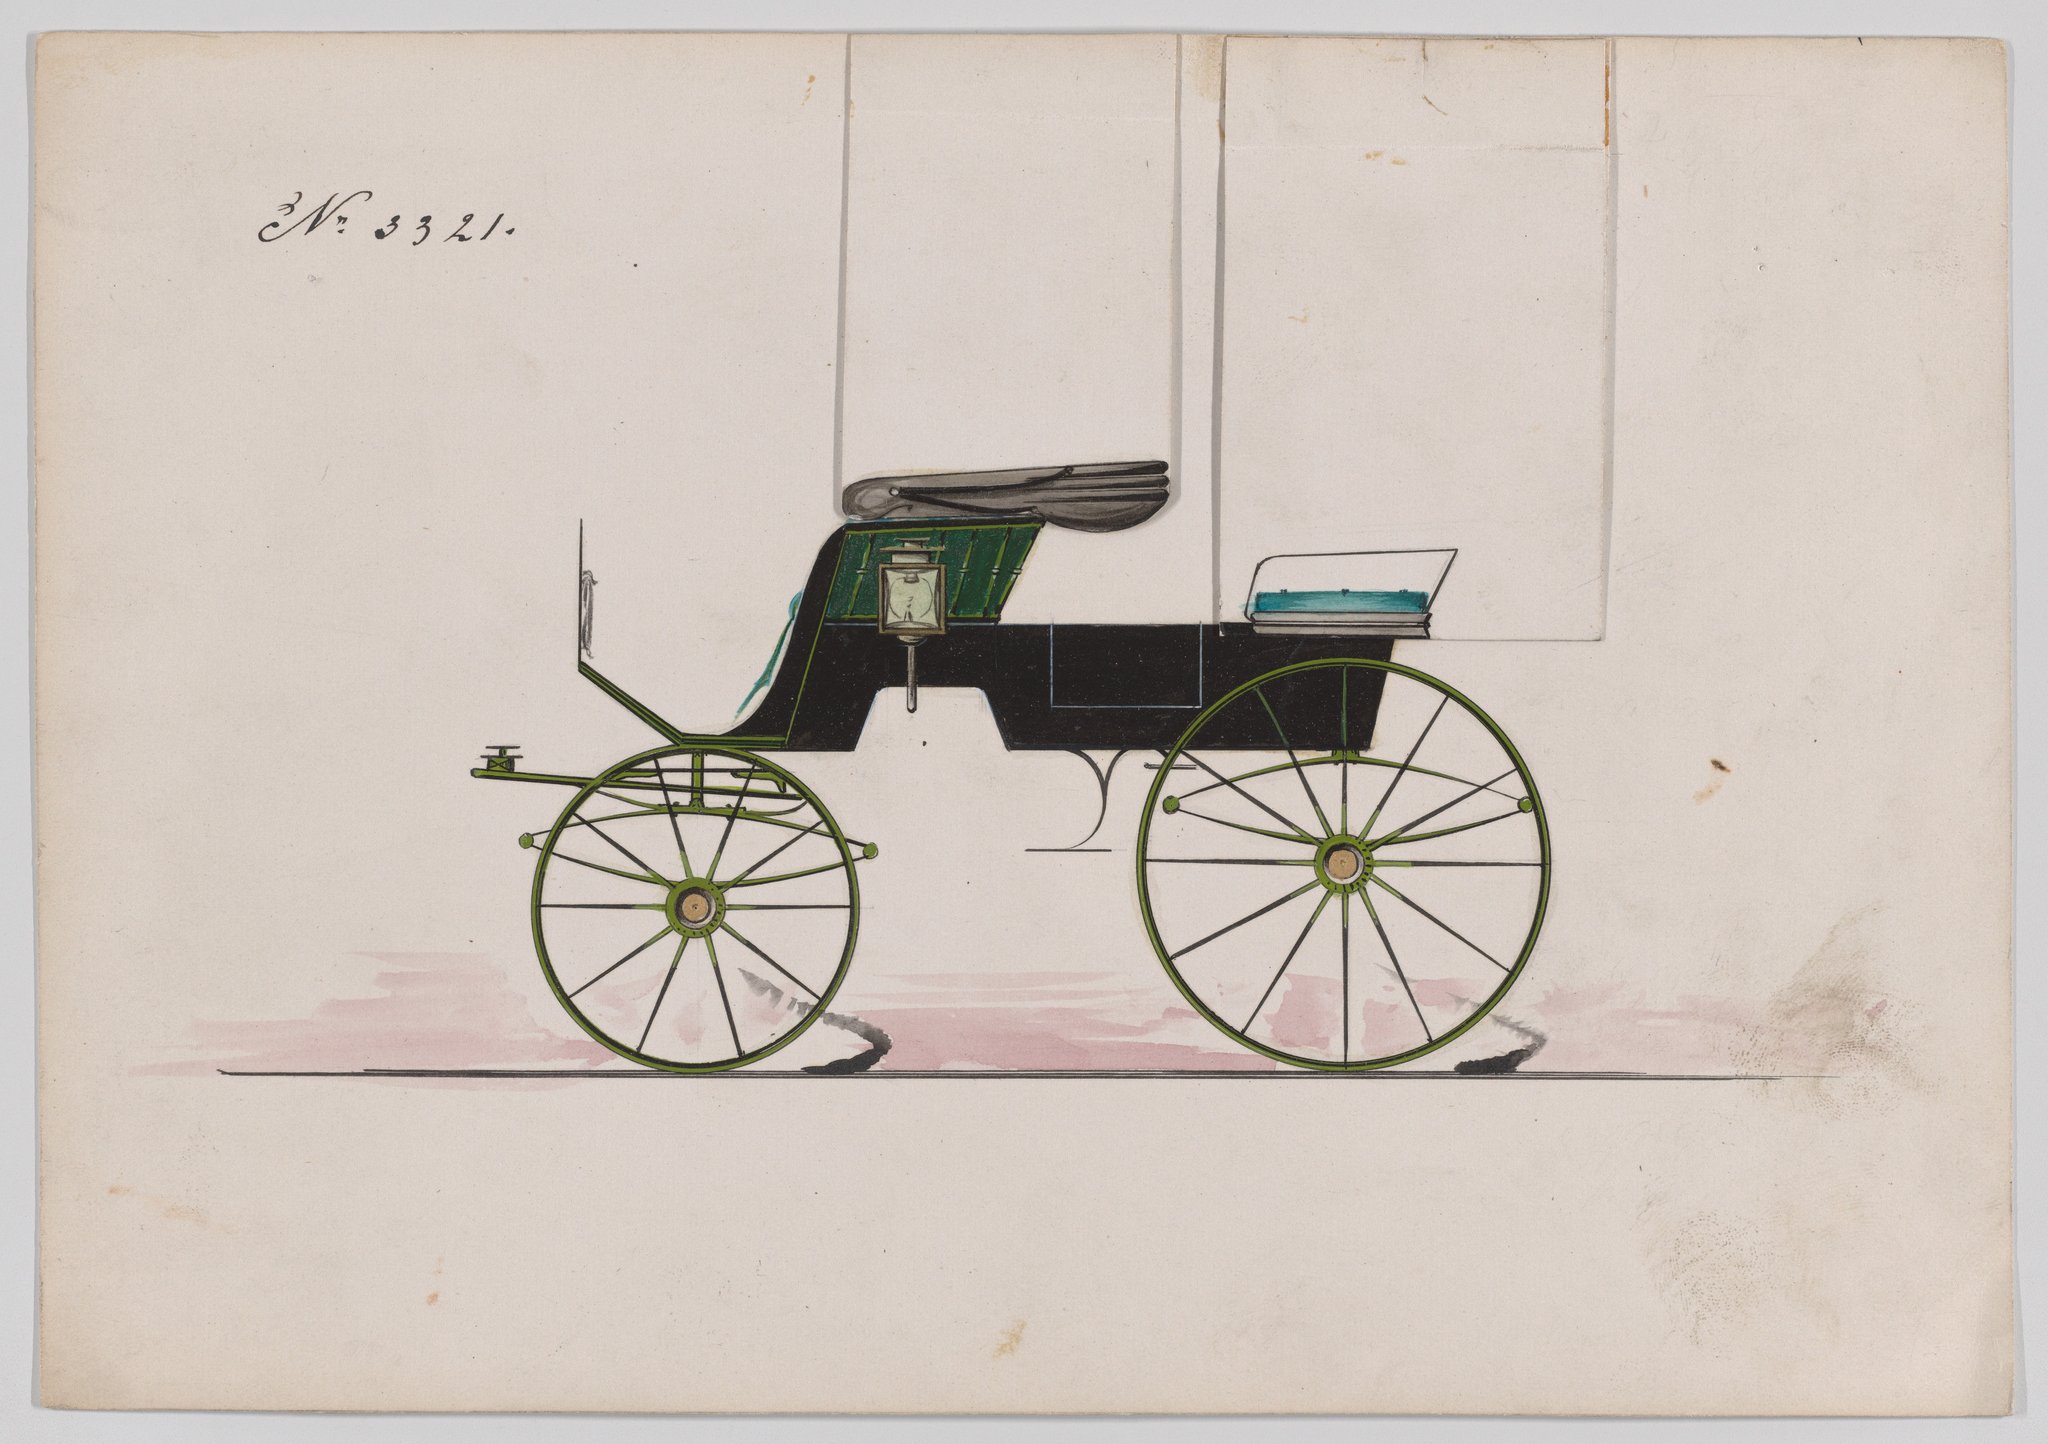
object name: drawing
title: Design for 2 seat Phaeton, no. 3321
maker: brewster & co.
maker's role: manufacturer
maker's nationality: american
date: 1877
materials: gouache, ink, watercolor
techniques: pen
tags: carriages